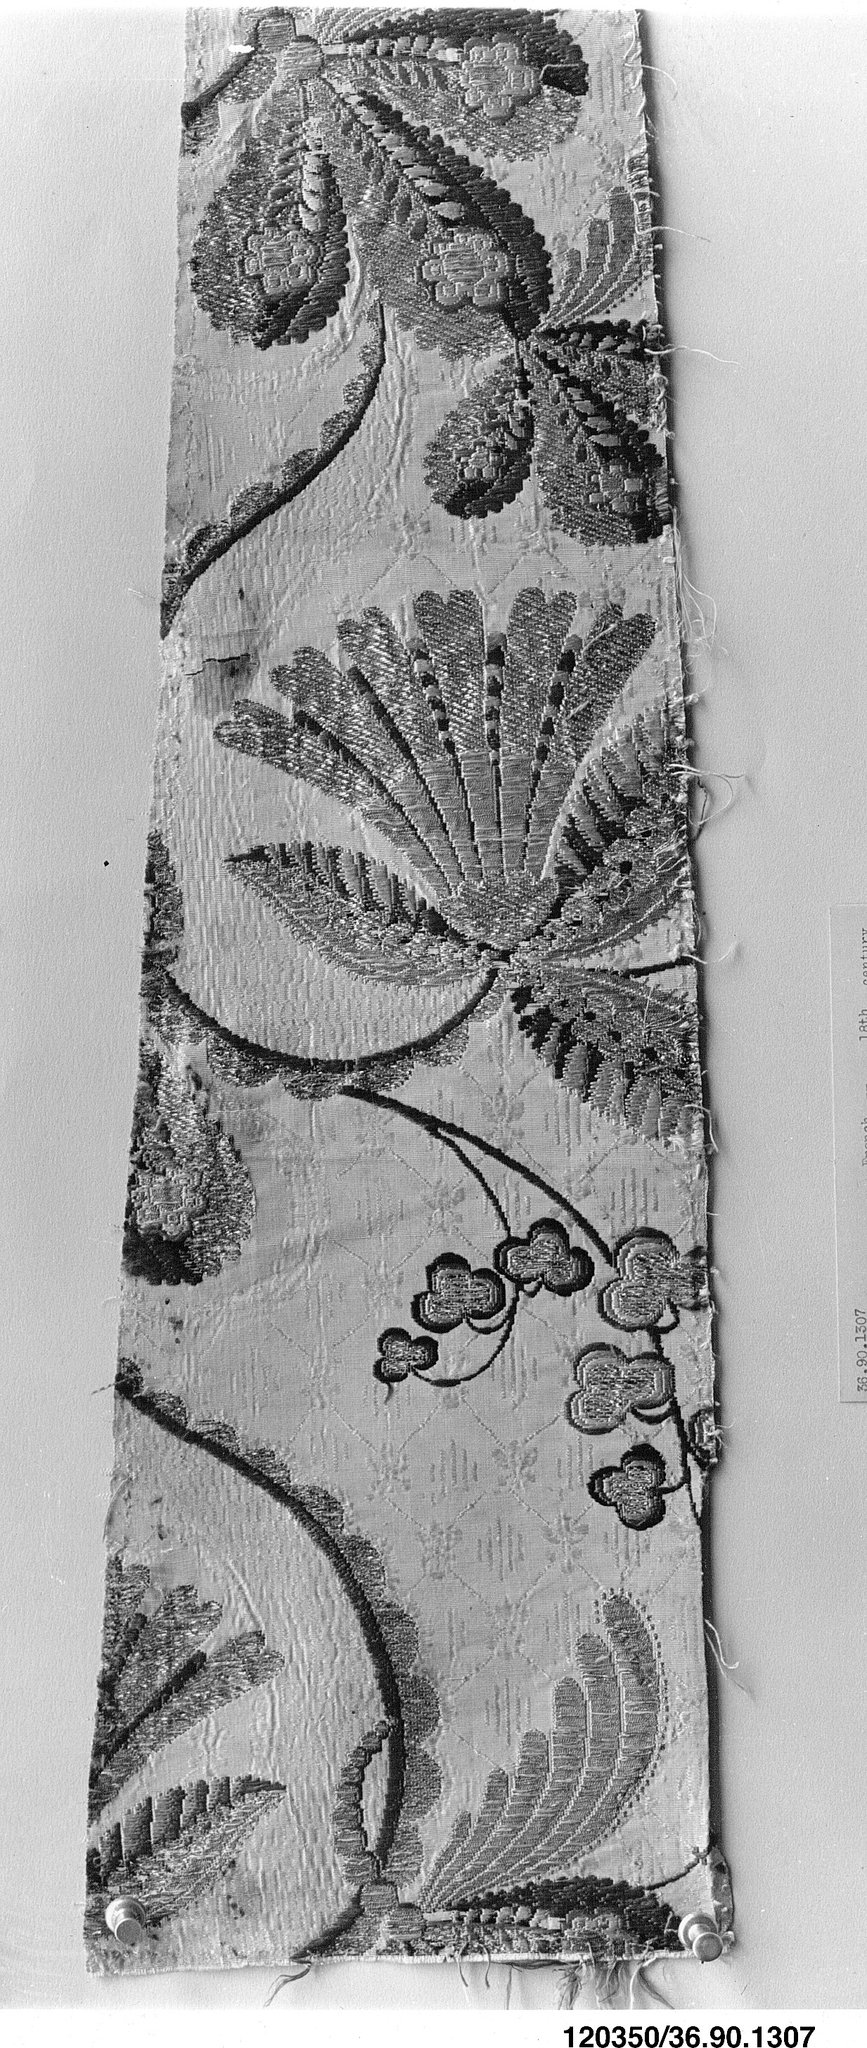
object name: piece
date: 1701-1800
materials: metal thread, silk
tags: flowers,leaves